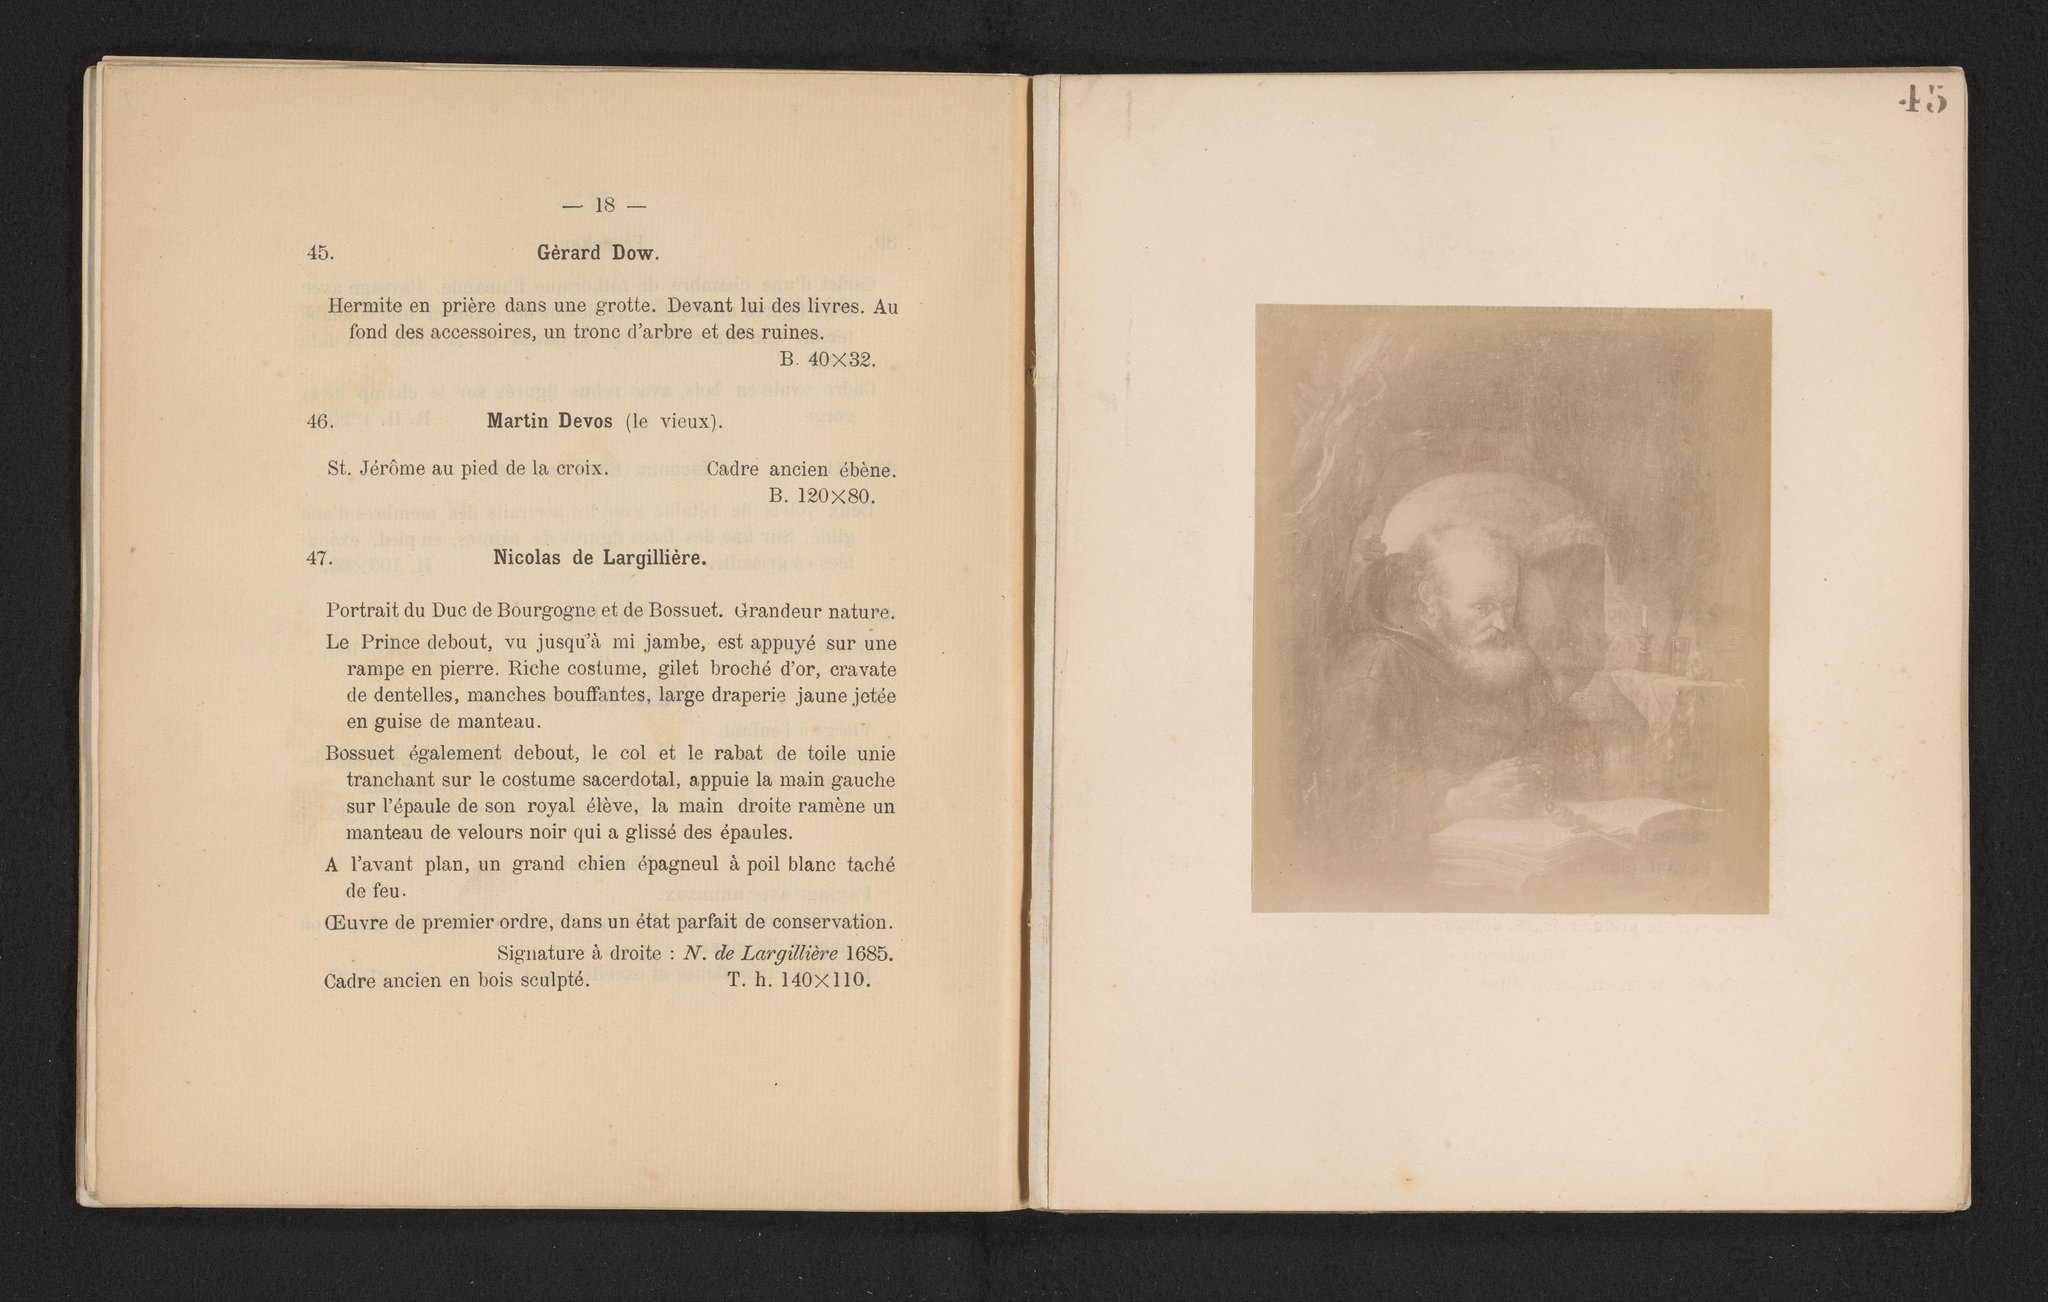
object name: page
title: Fotoreproductie van een schilderij van een biddende kluizenaar door Gerard Dou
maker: Anonymous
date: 1882-1887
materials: photographic support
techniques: albumen print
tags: anchorite, hermit, one person praying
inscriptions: number: ‘45’